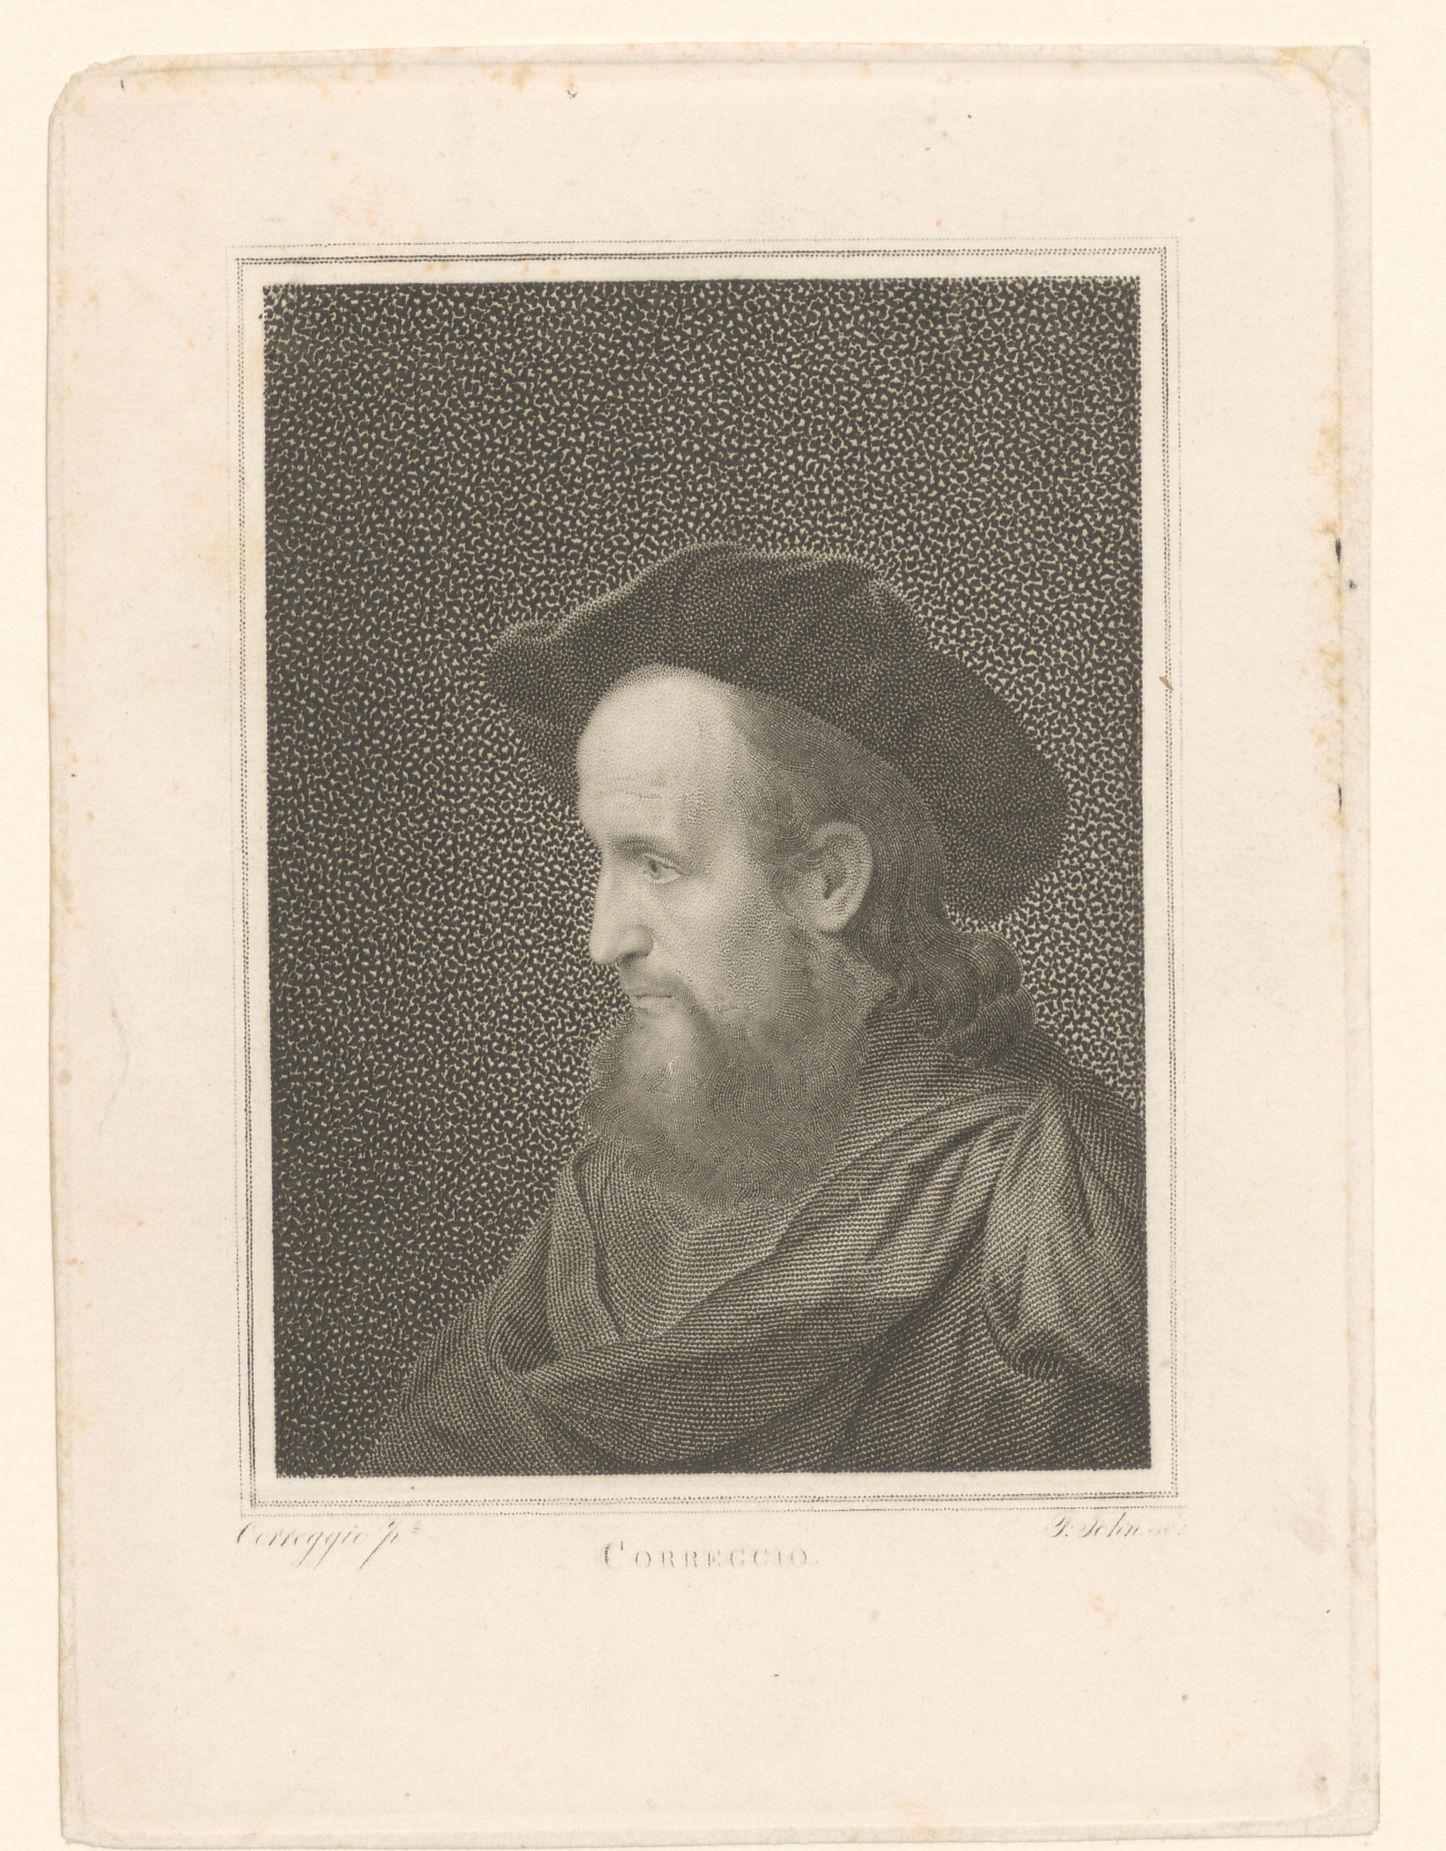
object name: print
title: Portret van Correggio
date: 1779-1843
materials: paper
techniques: stippling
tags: painter, print maker, draughtsman, correggio, historical persons, portrait, self-portrait of painter, portrait, self-portrait of graphic artist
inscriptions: collector's mark: Lugt 2228